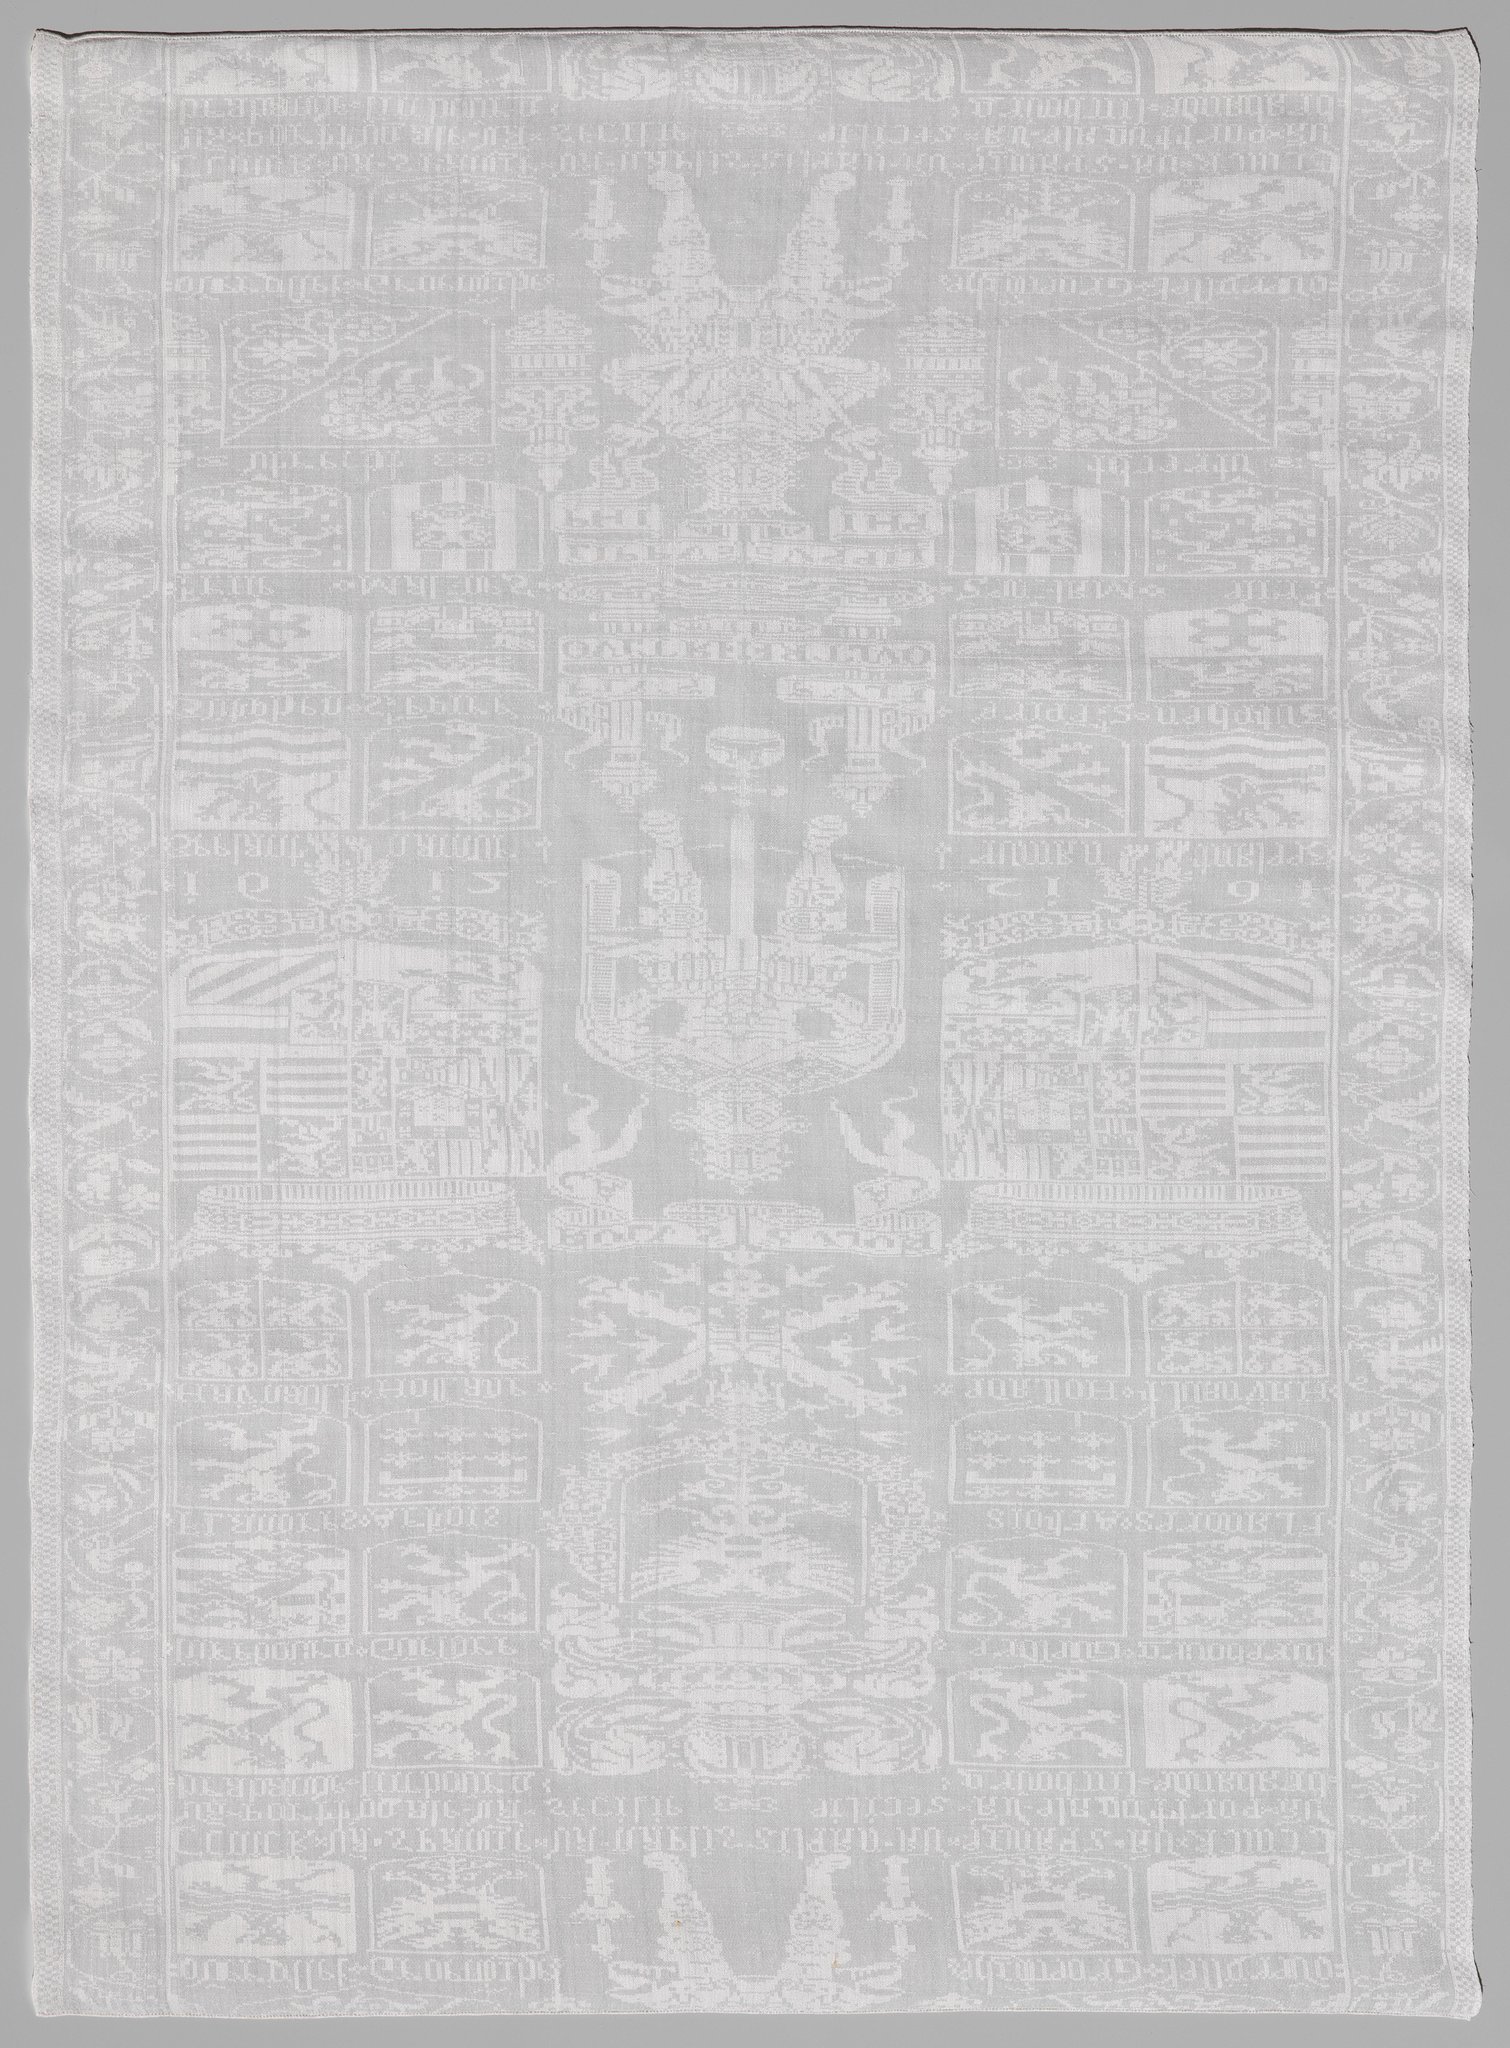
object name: napkin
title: Servet met het Plus Oultre-patroon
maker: Anonymous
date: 1612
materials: linen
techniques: damask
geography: flanders